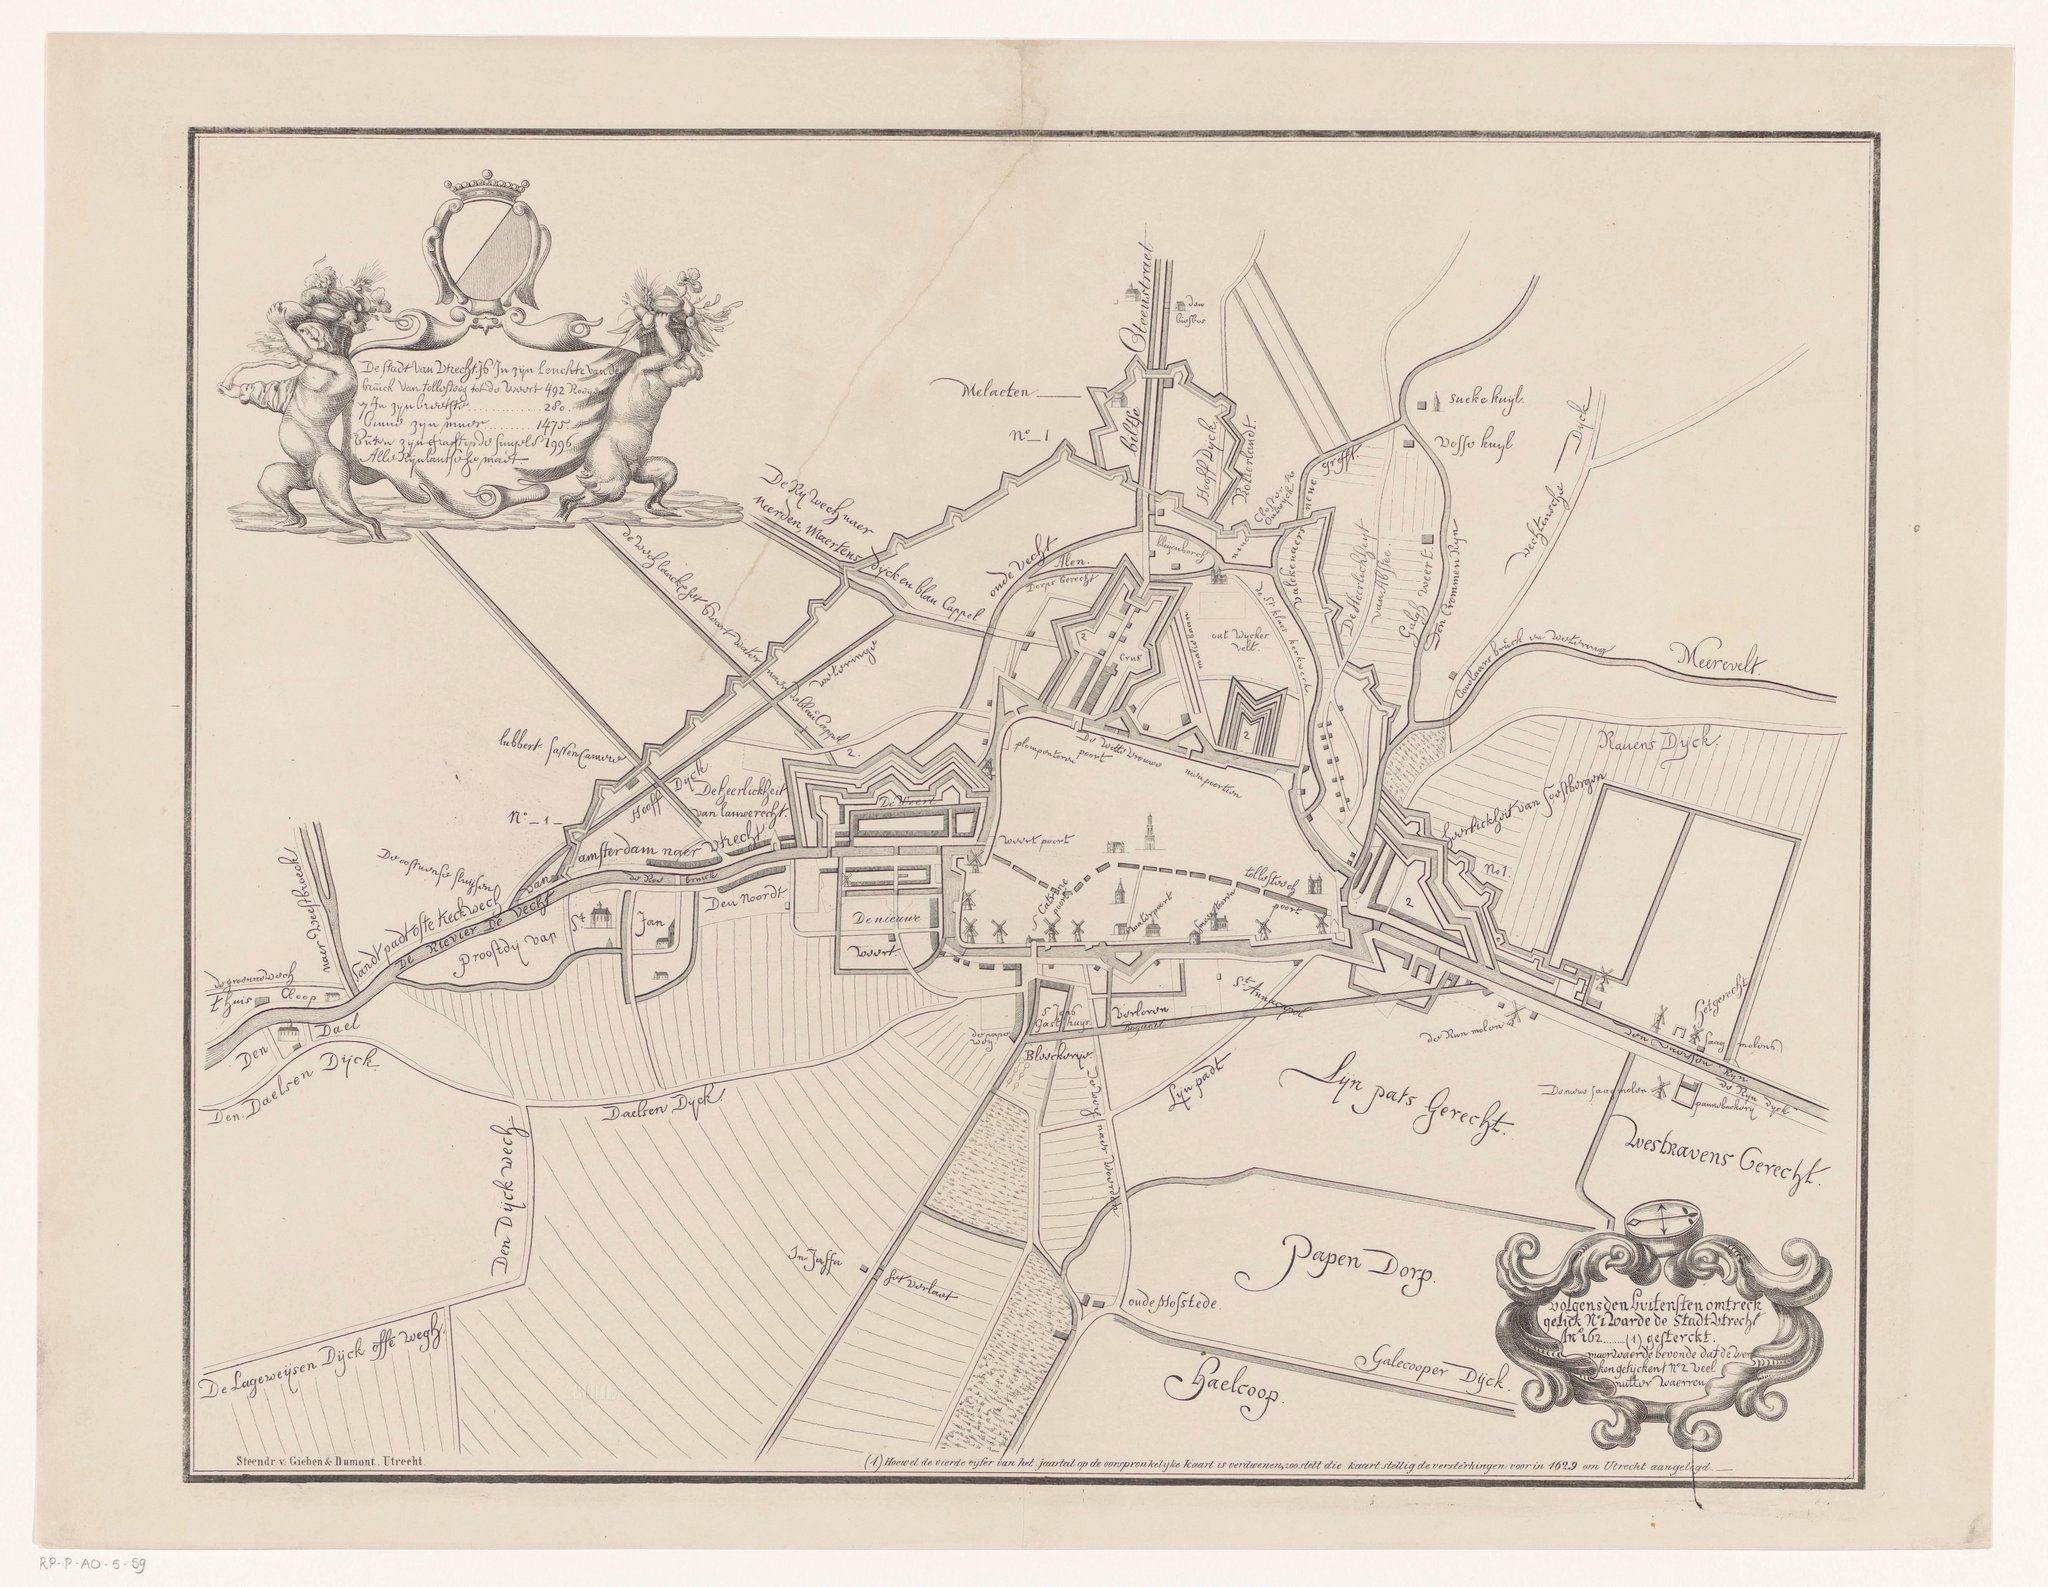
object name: area plan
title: De stadt van Utrecht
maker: Anonymous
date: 1856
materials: paper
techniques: lithograph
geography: utrecht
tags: coat of arms (as symbol of the state, etc.), maps of cities, utrecht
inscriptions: check stamp: ‘Archief Ministerie van Oorlog Afdeeling Genie’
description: Negentiende-eeuwse steendrukkopie van een ongedateerde zeventiende-eeuwse handschriftkaart gemaakt naar aanleiding van fortificatieplannen uit 1629. Linksboven een cartouche met topografische informatie en vermelding van de gebruikte schaal: Rijnlantsche maet. Boven de cartouche het wapen van de stad Utrecht. Rechtsonder een cartouche met informatie over de kaart.